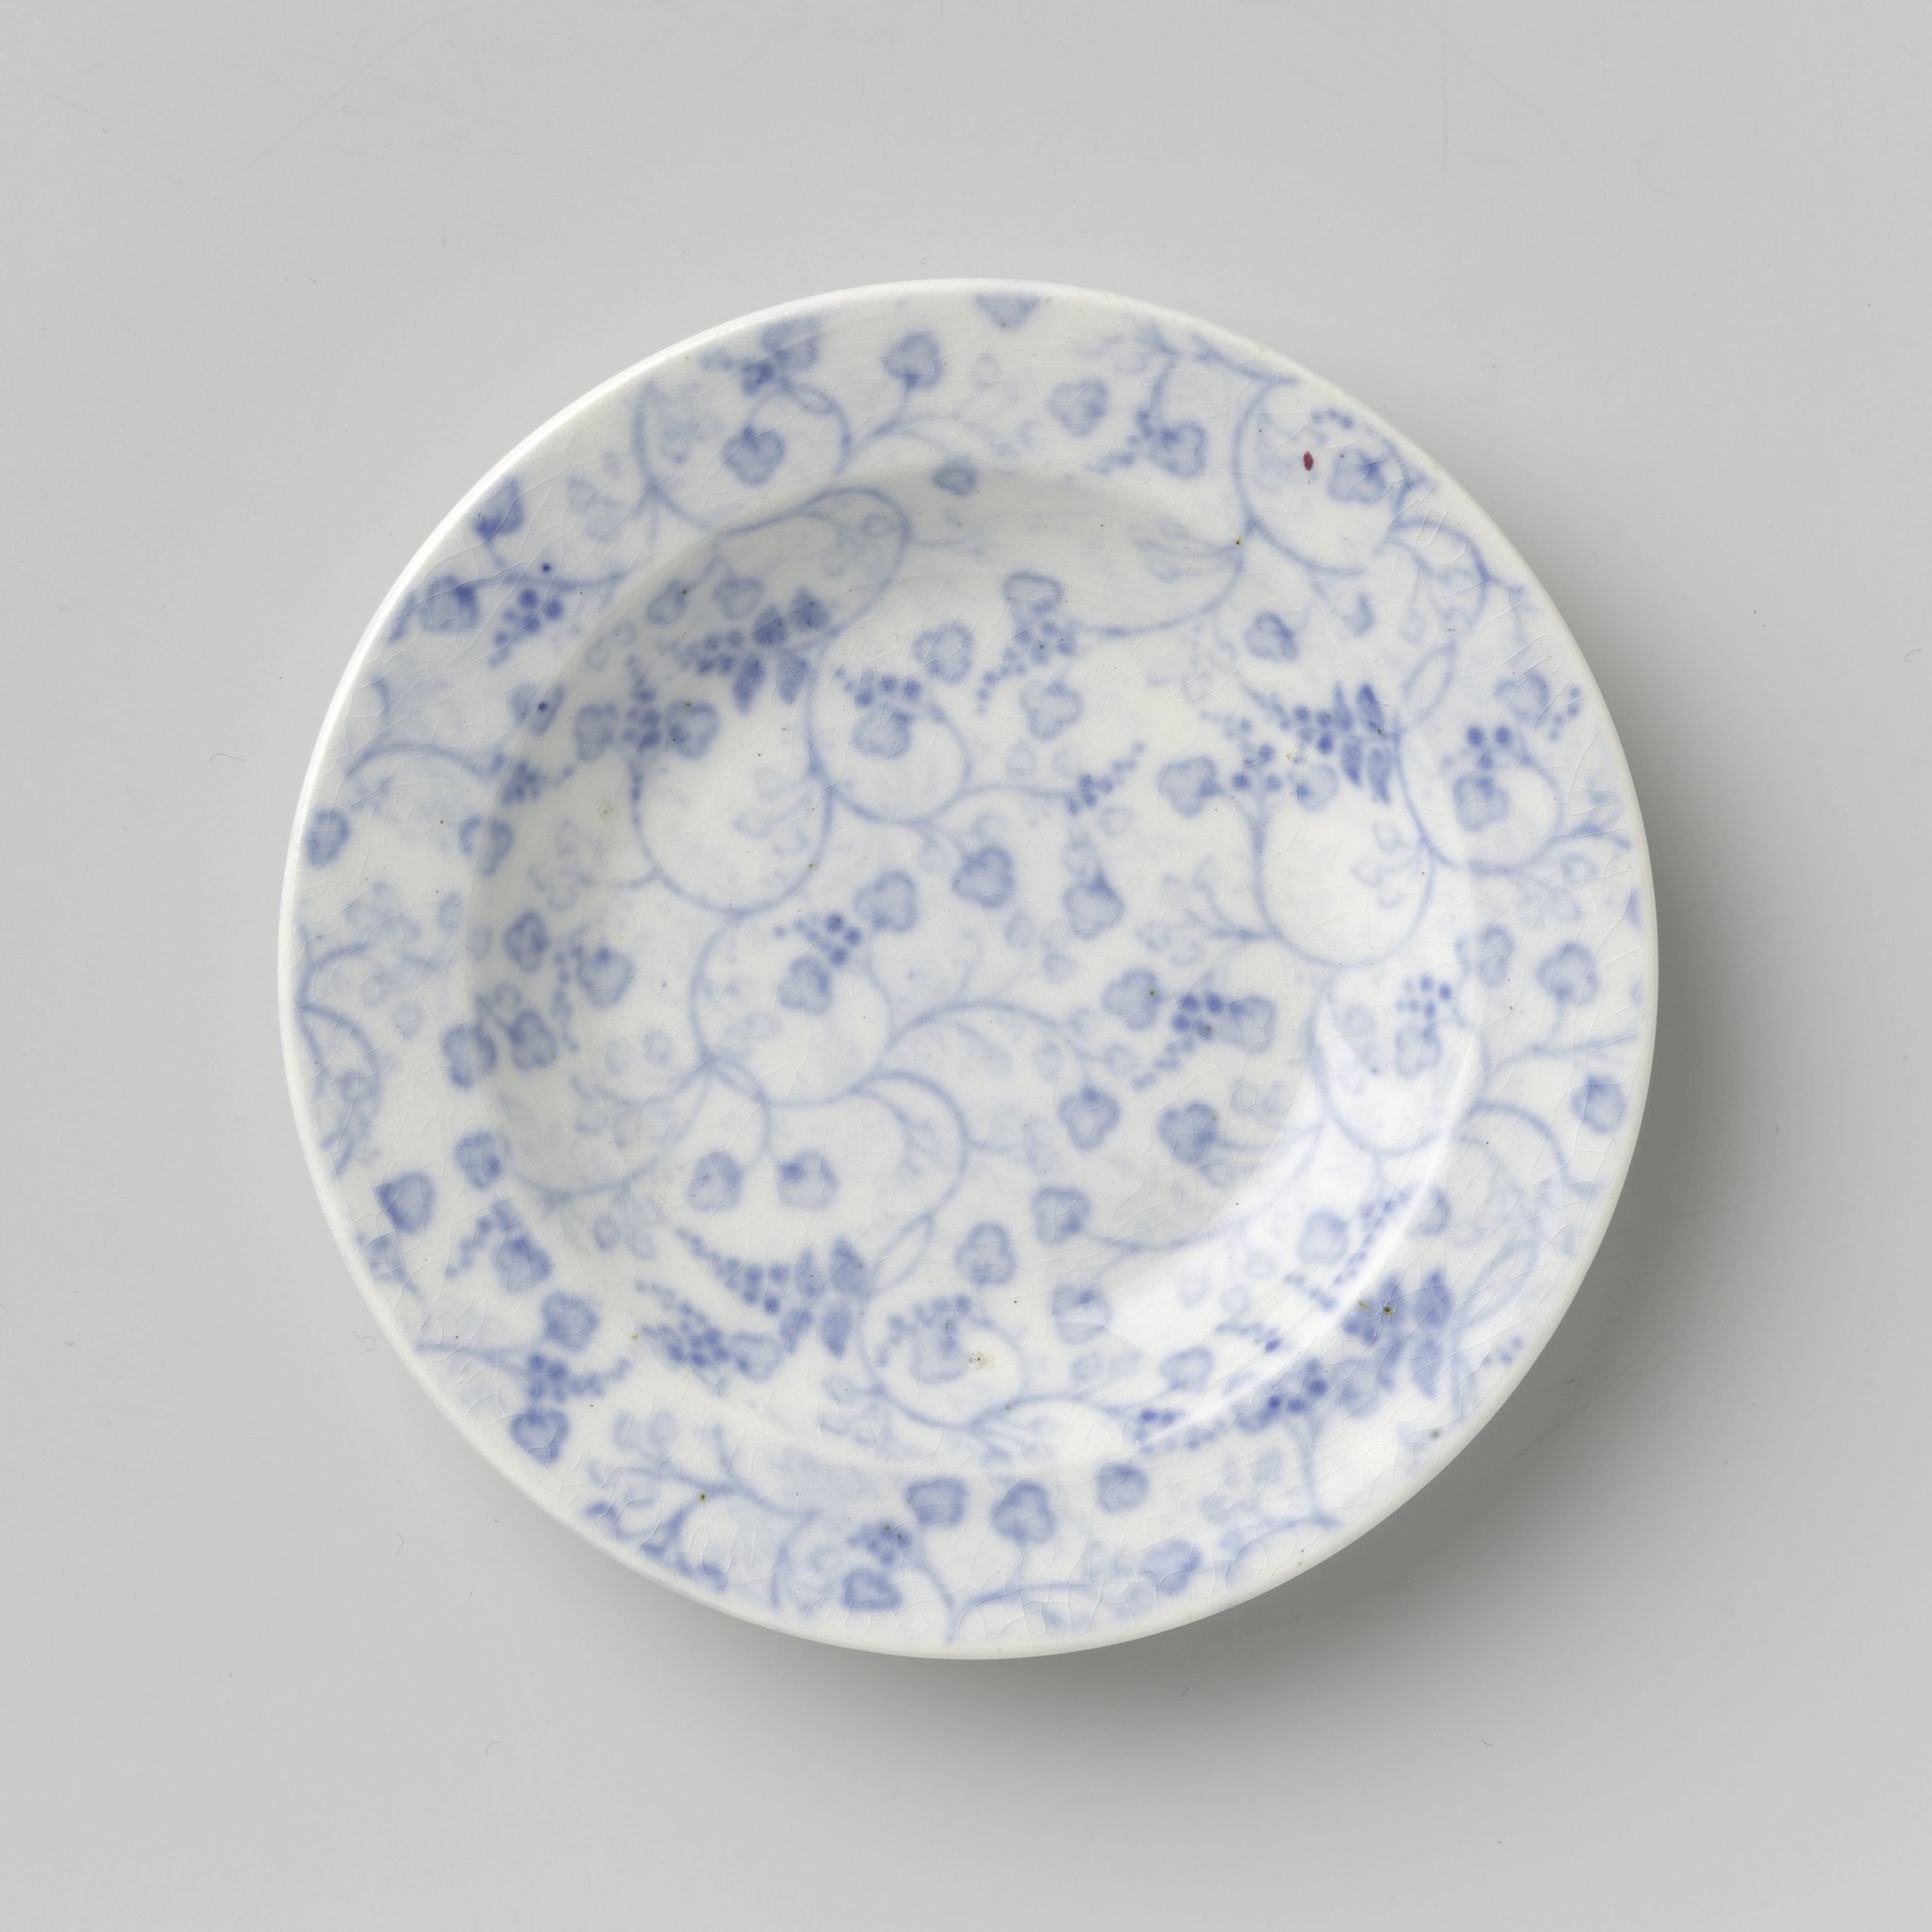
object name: plate dish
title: Bord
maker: petrus regout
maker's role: plateelbakker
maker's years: 1801-1879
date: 1867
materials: creamware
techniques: transfer decoration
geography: maastricht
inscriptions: check stamp: ‘PR’, mark: ‘PARSEME No 3’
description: Bord van aardewerk, met blauw doorlopend bloemendecor, behorend tot een kinderservies.